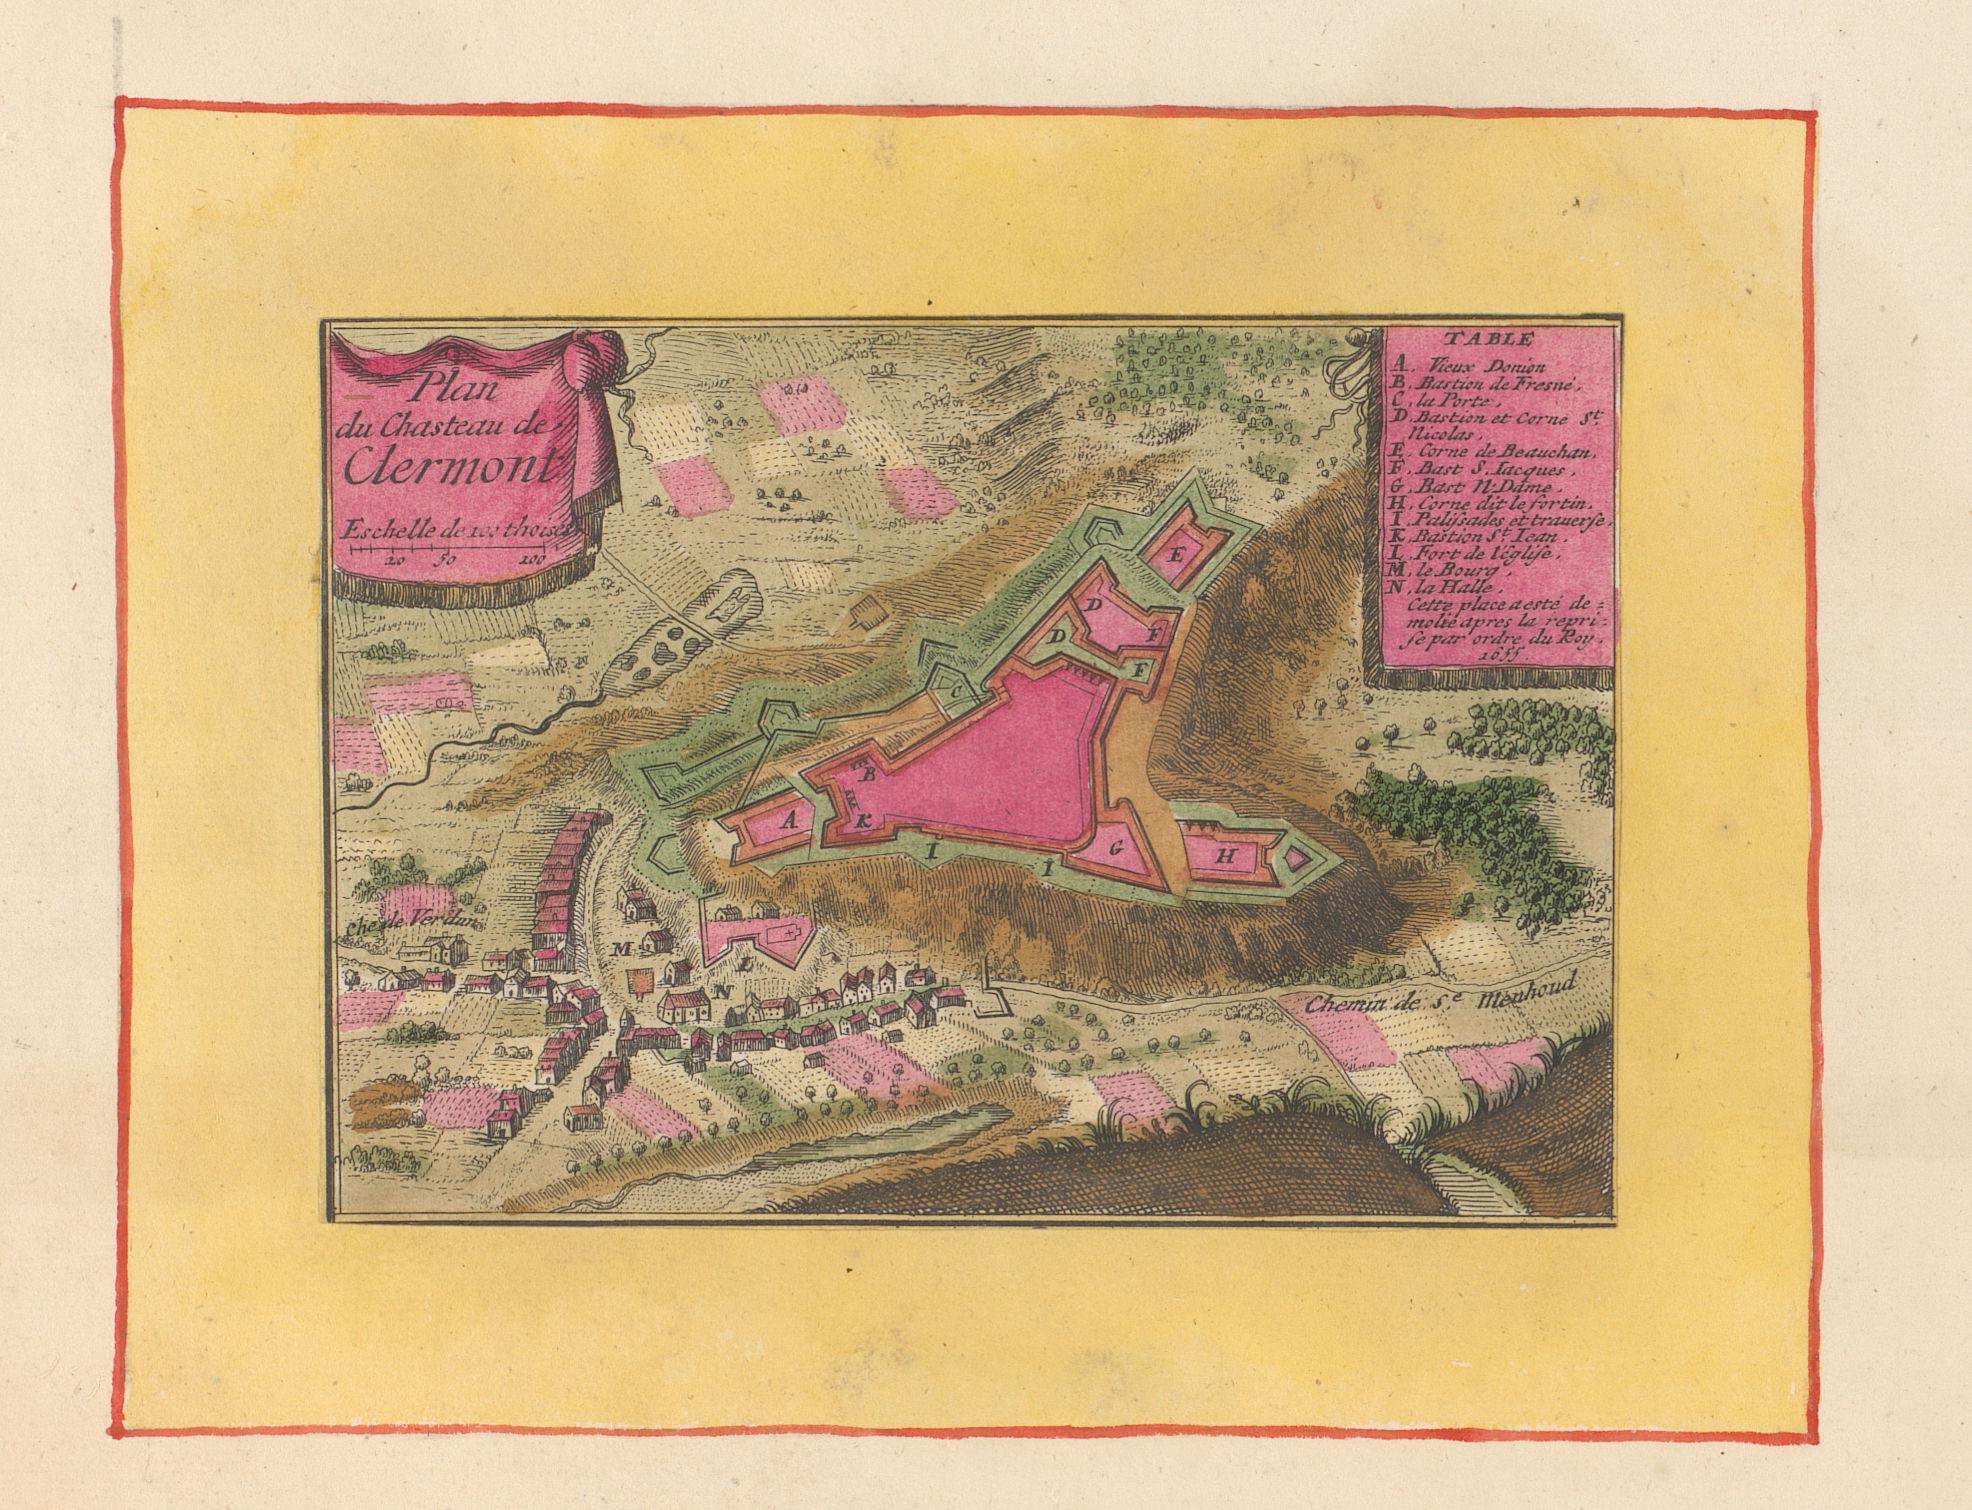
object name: album leaf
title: Plattegrond van het kasteel van Clermont-en-Argonne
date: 1700-1702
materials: paper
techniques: engraving, etching, hand coloring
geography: amsterdam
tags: maps of cities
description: Deze plattegrond is in meerdere atlassen gebruikt. Onder andere in: Les forces de l'Europe. 10 dln. Amsterdam: Pieter Mortier, ca. 1700. En in: Les forces de l'Europe. 12 dln. Amsterdam: Pieter Mortier, 1702. Door het ontbreken van de marges van deze prent is onduidelijk om welke staat het gaat. Derhalve is niet te bepalen uit welke van deze publicaties dit exemplaar komt. Later is deze zelfde prent door Pieter van der Aa gebruikt in twee publicaties. Gezien het eind van de werkzame periode van de inkleurder van de prenten in dit album is het niet mogelijk dat deze prent uit een van die publicaties komt.